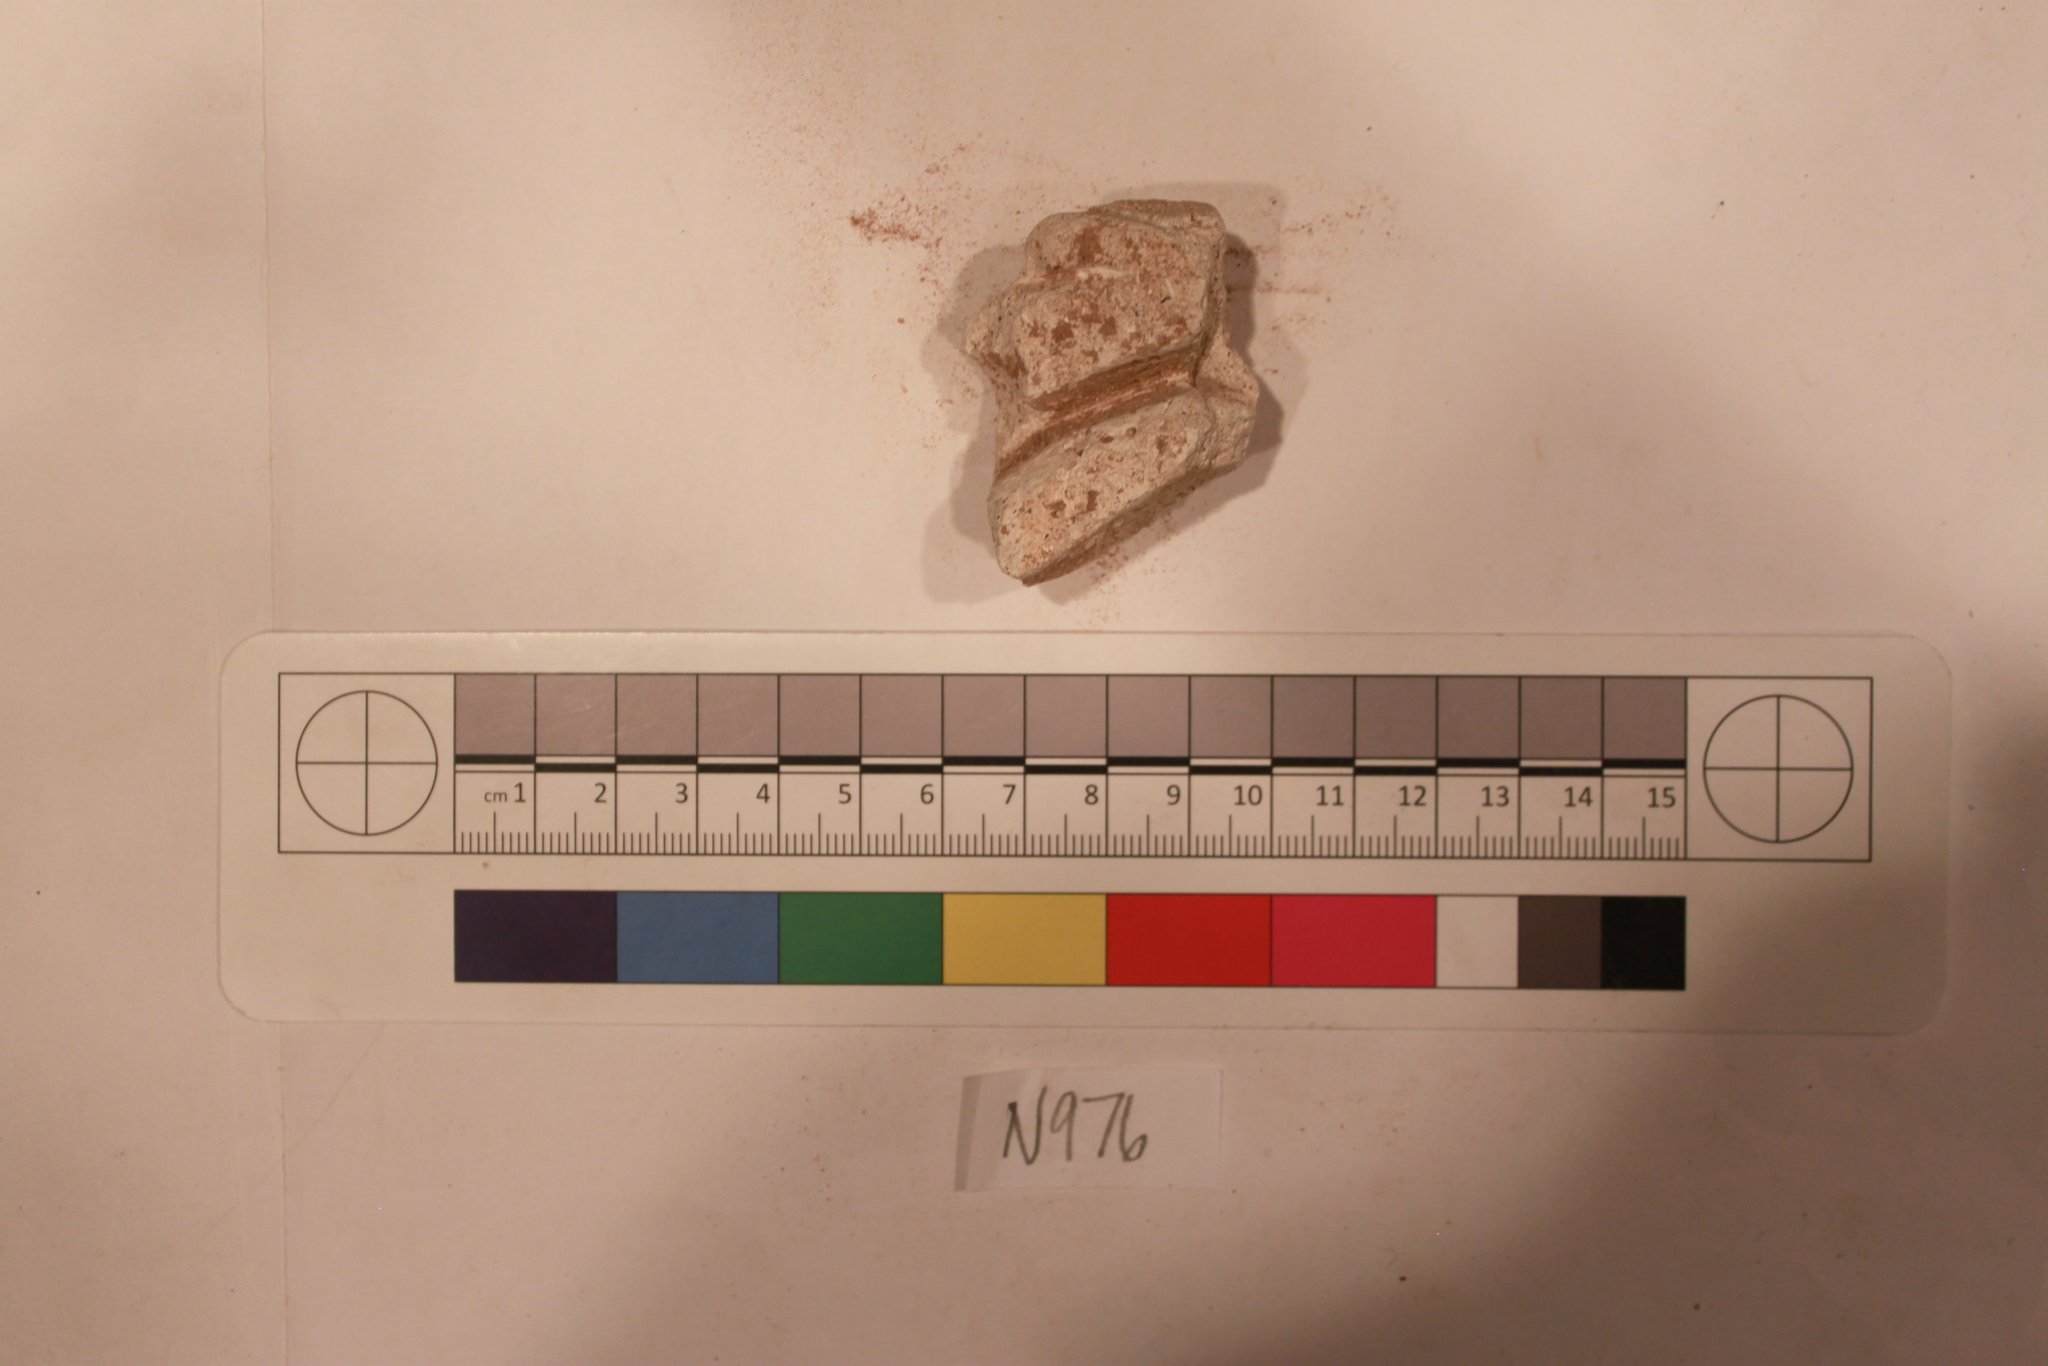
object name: fragment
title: Stucco Fragment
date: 701-1200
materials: plaster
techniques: carving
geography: iran